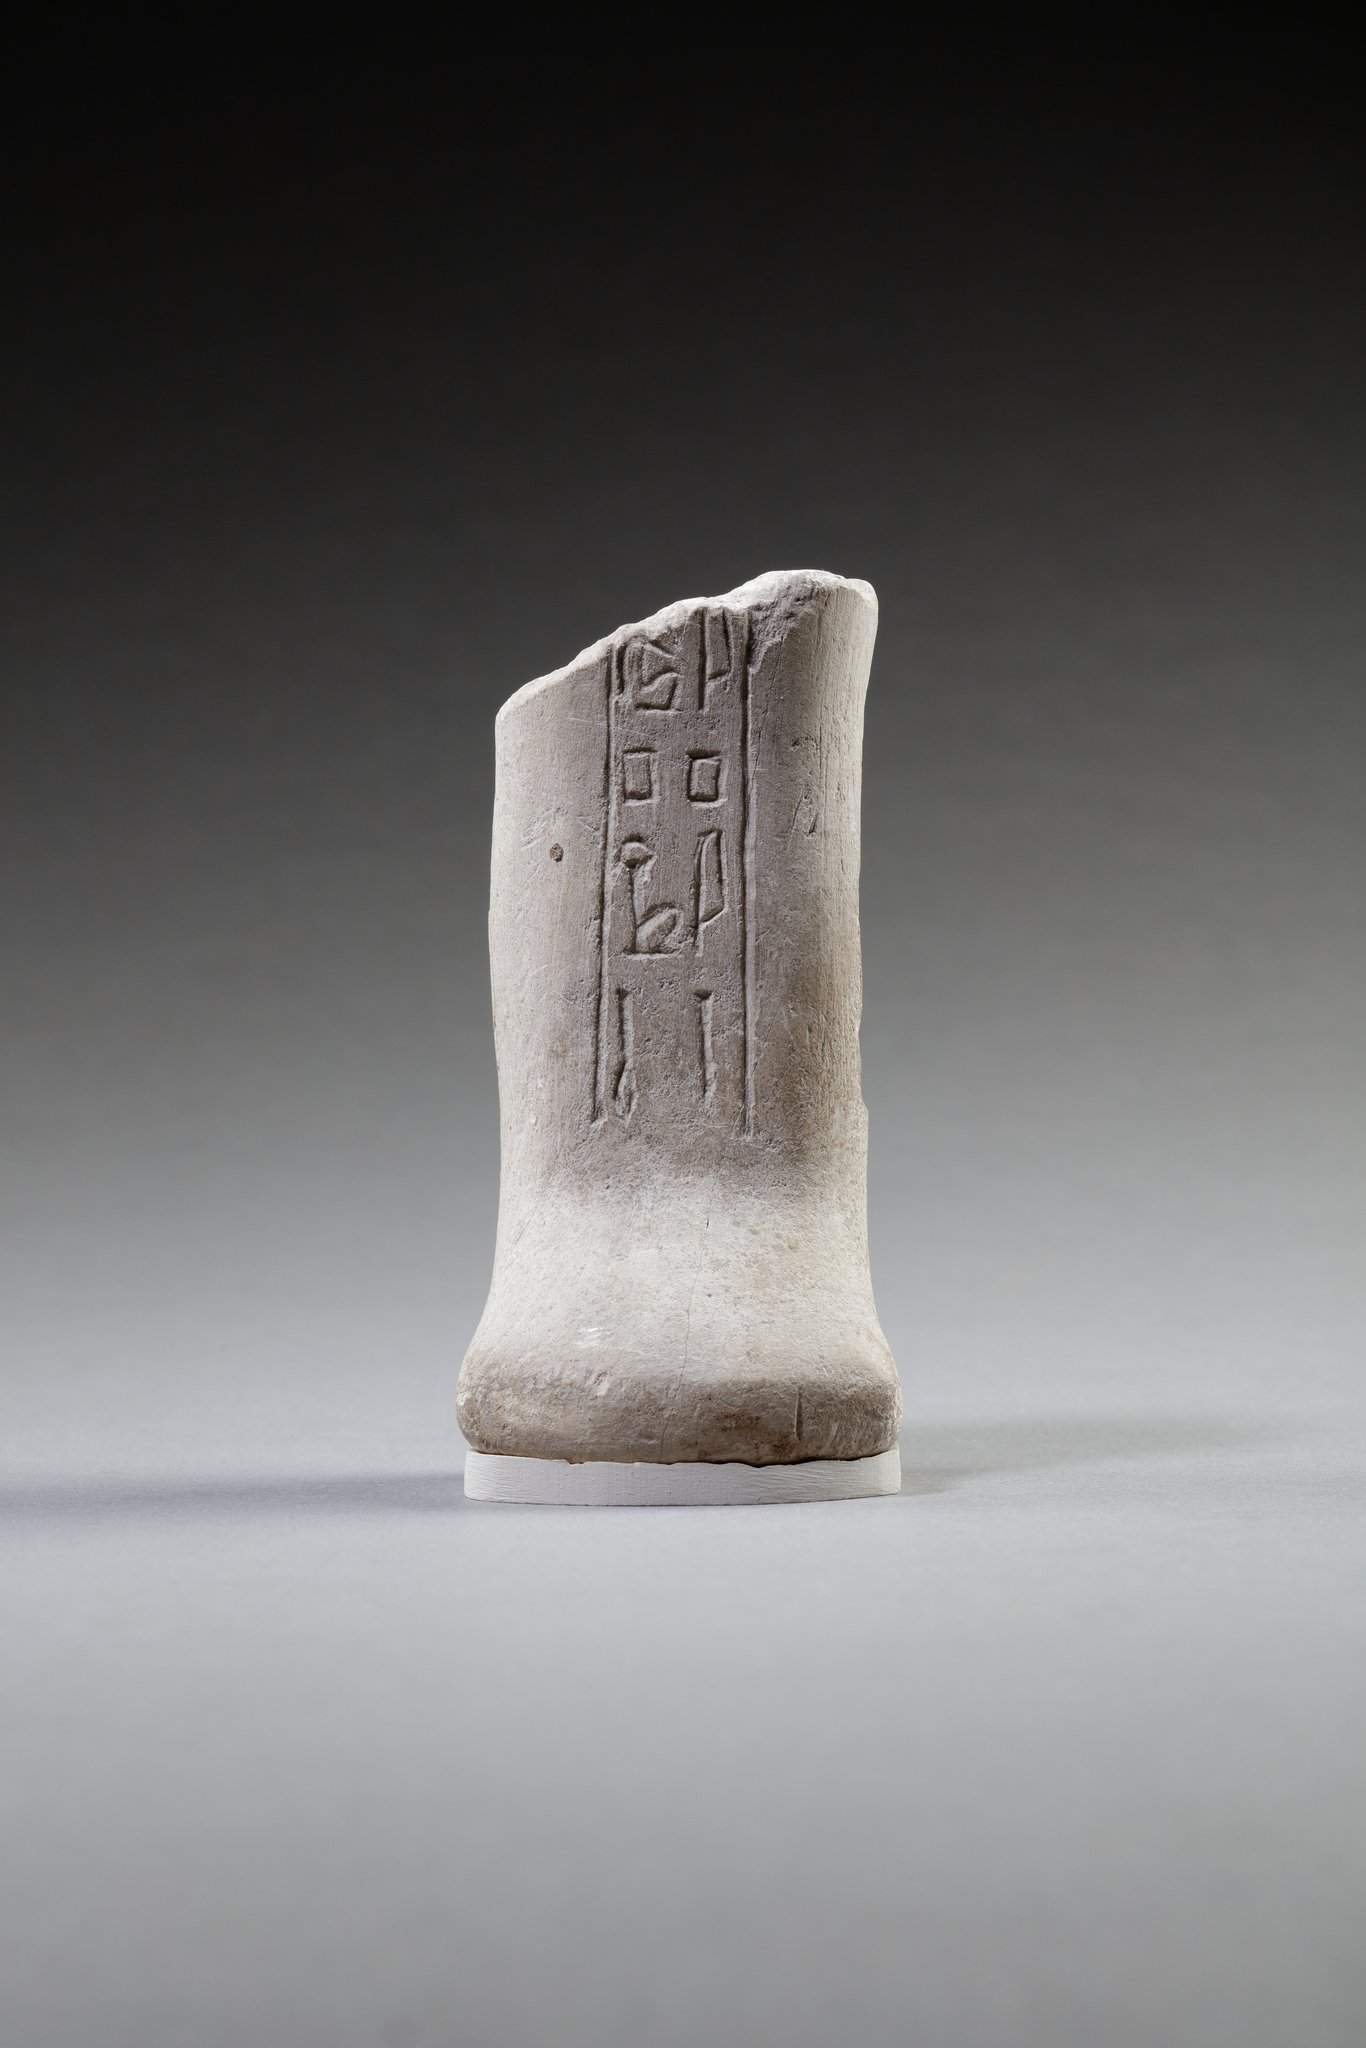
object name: shabti leg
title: Lower body of a shabti of a man called Apepi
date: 1981-1550 BCE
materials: limestone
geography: egypt